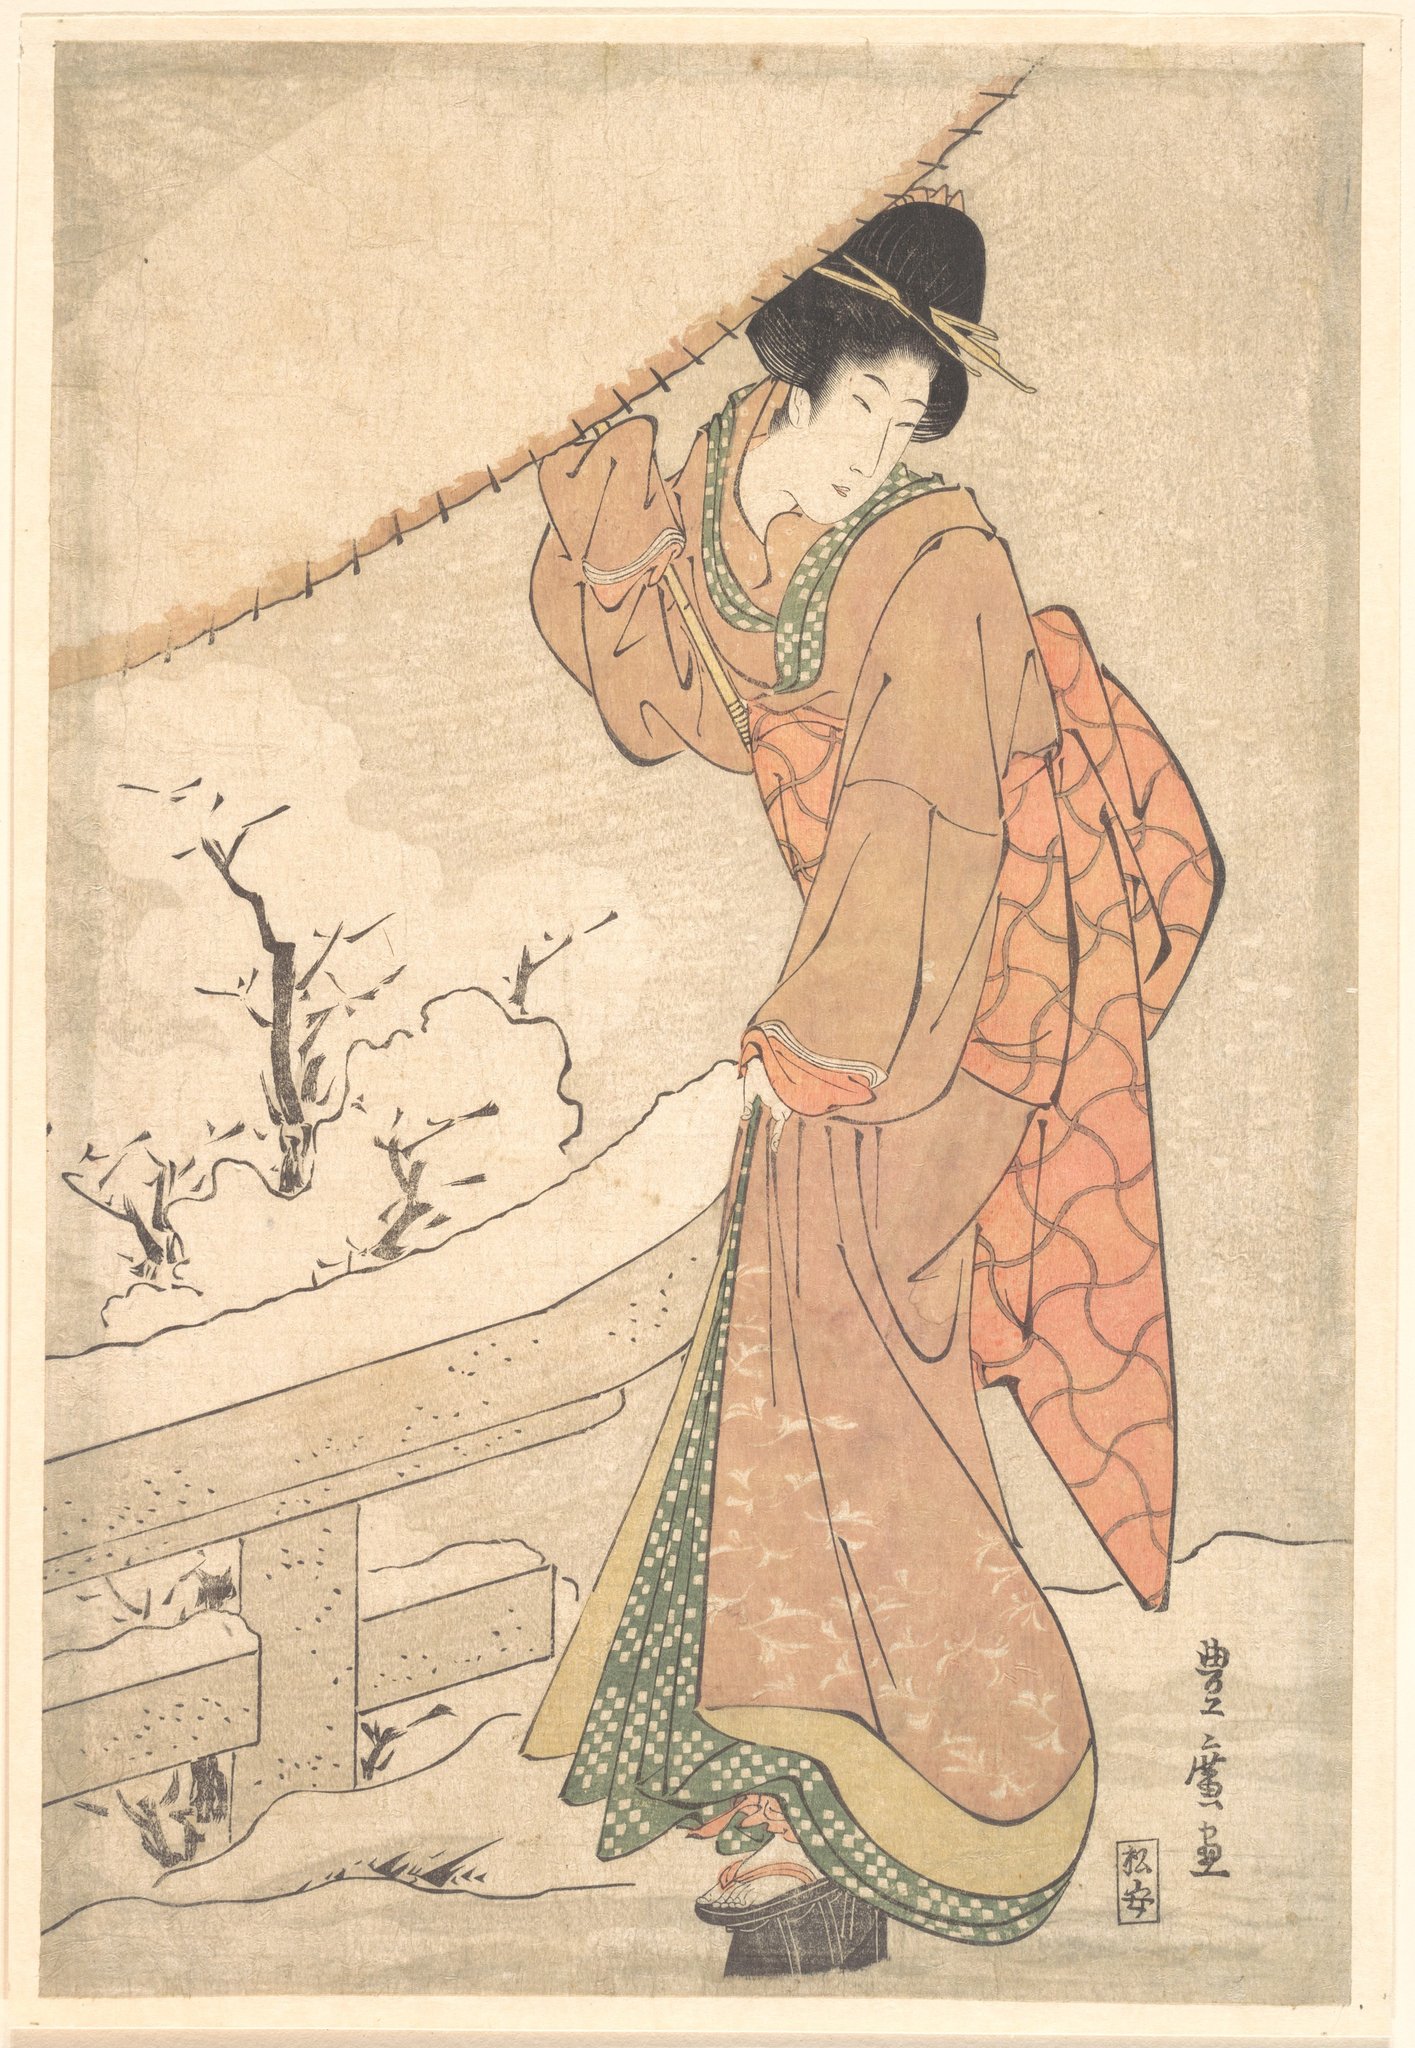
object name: print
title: A Young Woman in a Snow Storm Carrying a Heavily Snow-Laden Umbrella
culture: japanese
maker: utagawa toyohiro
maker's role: artist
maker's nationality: japanese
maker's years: 1763-1828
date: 1802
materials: ink, paper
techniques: woodblock print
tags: women,snow,umbrellas